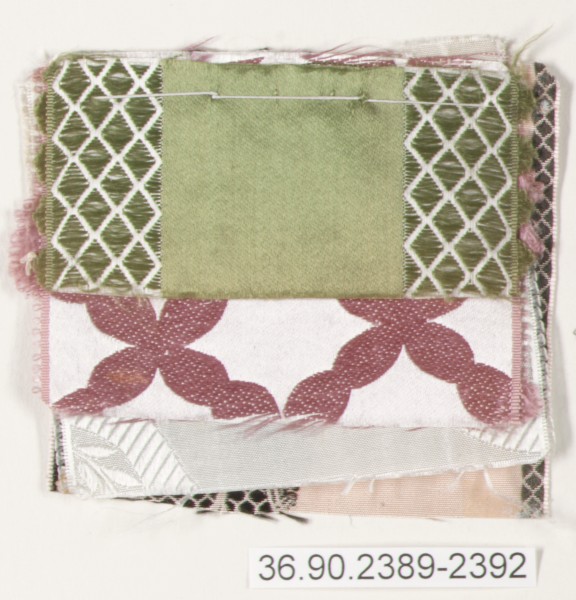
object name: ribbon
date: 1801-1900